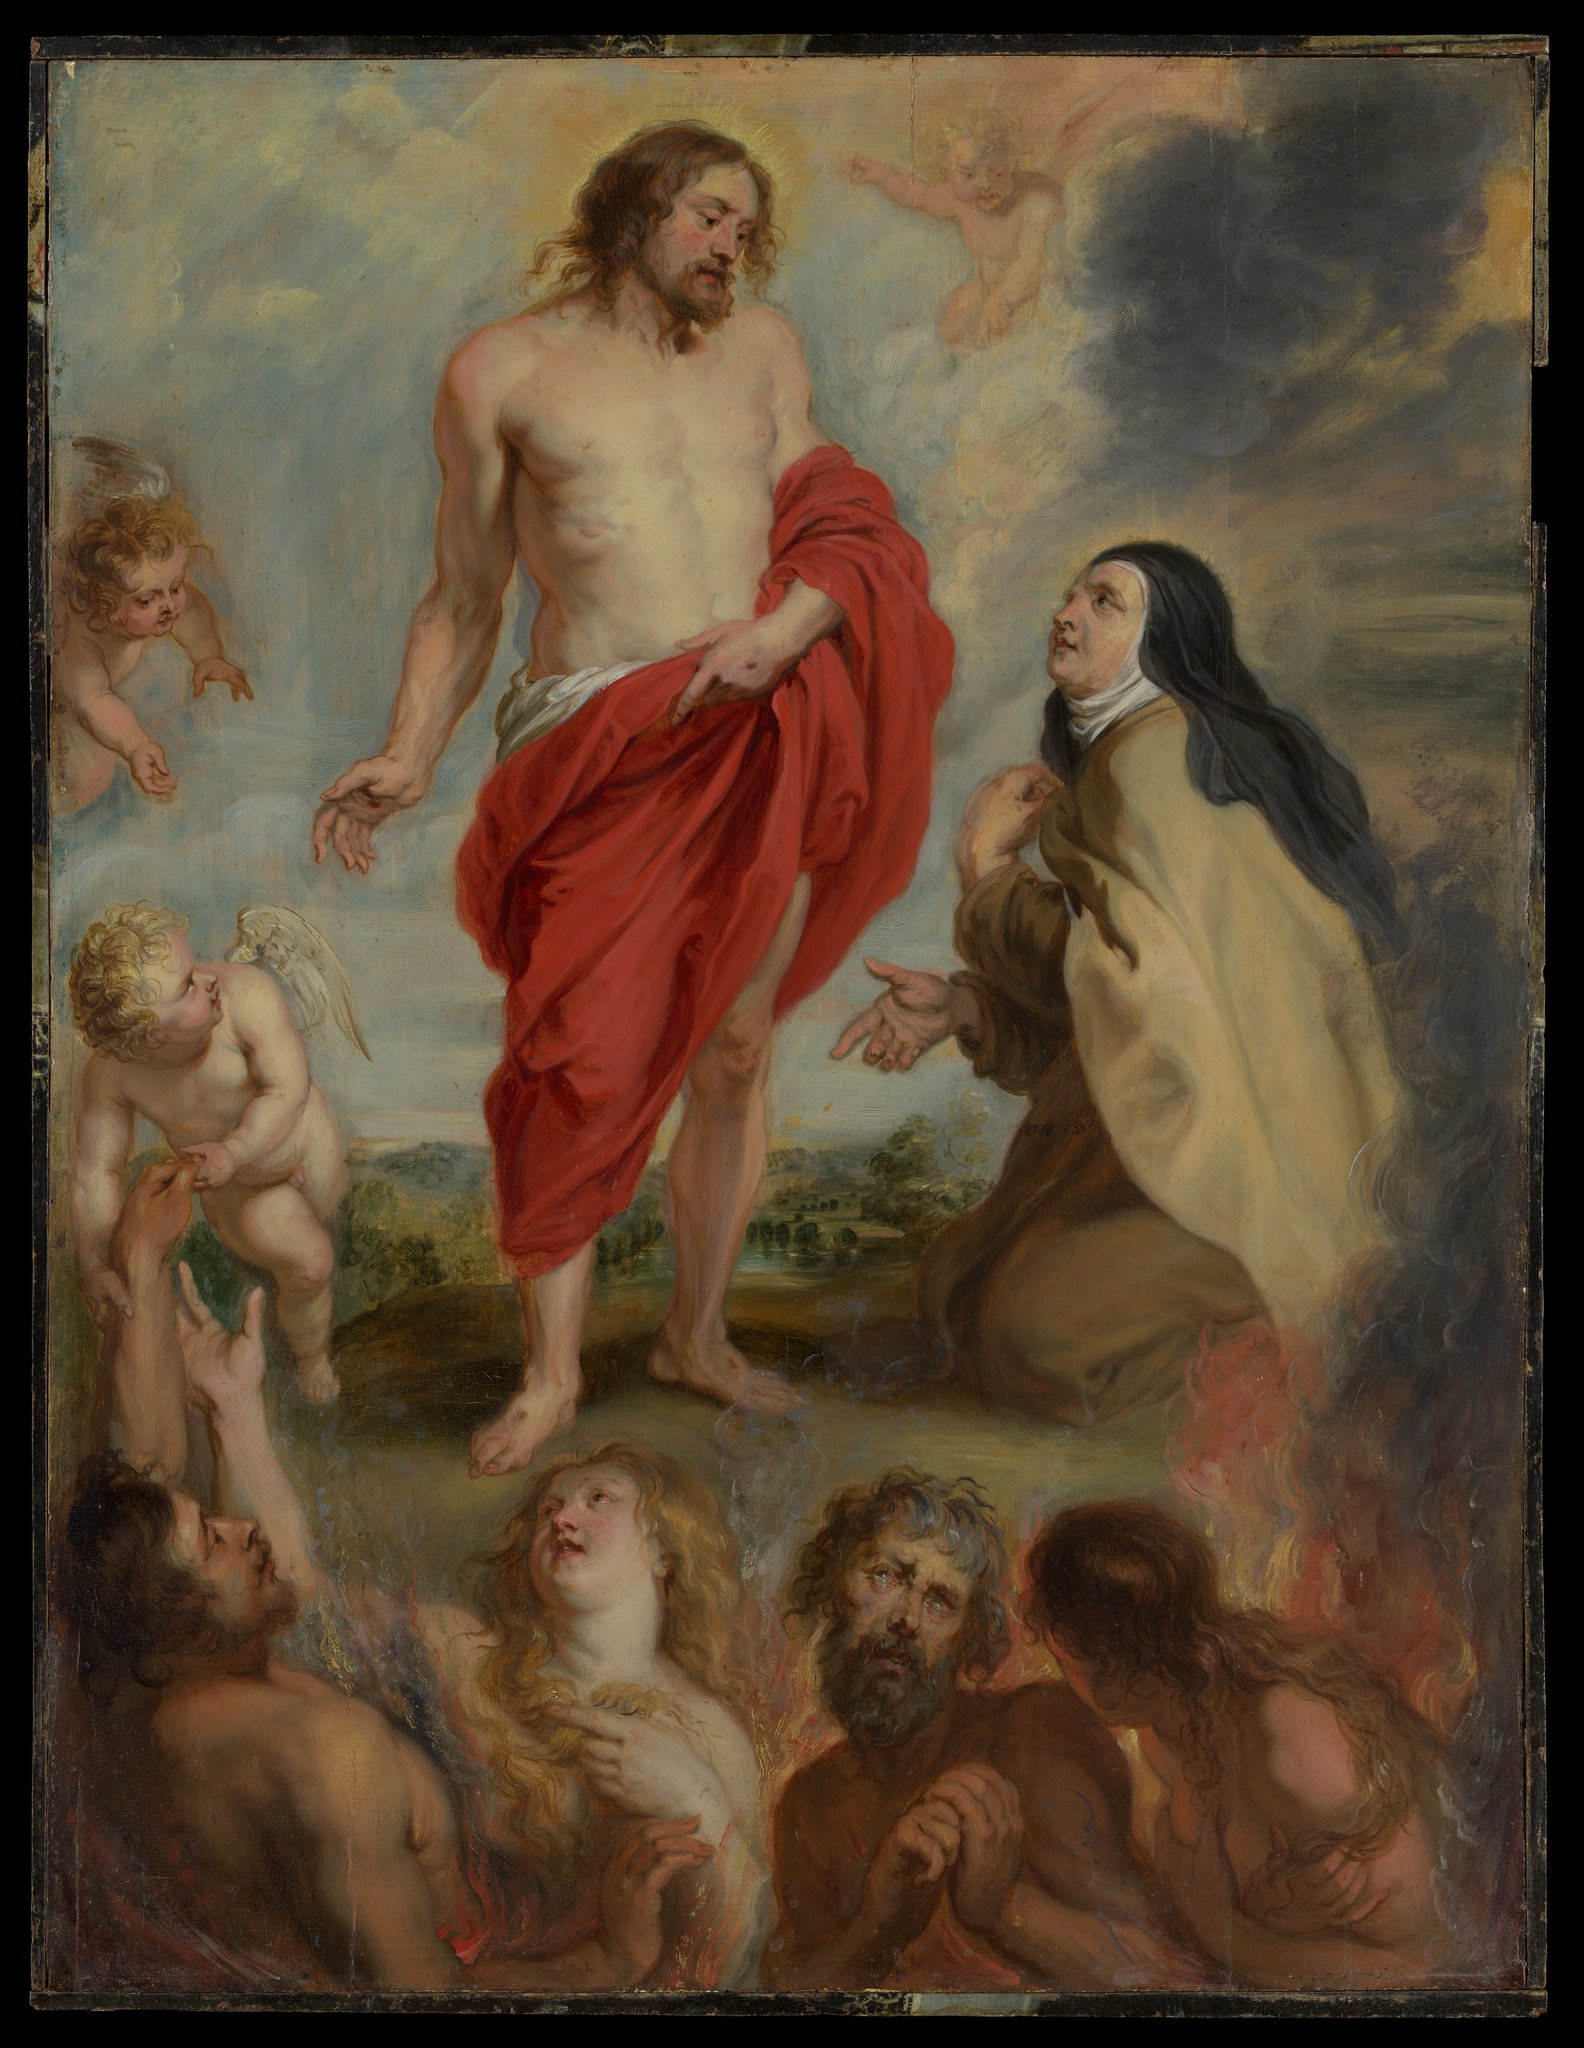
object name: painting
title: Saint Teresa of Avila Interceding for Souls in Purgatory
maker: peter paul rubens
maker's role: artist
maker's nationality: flemish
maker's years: 1577-1640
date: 1597-1640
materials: oil, wood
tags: men,women,angels,christ,saints